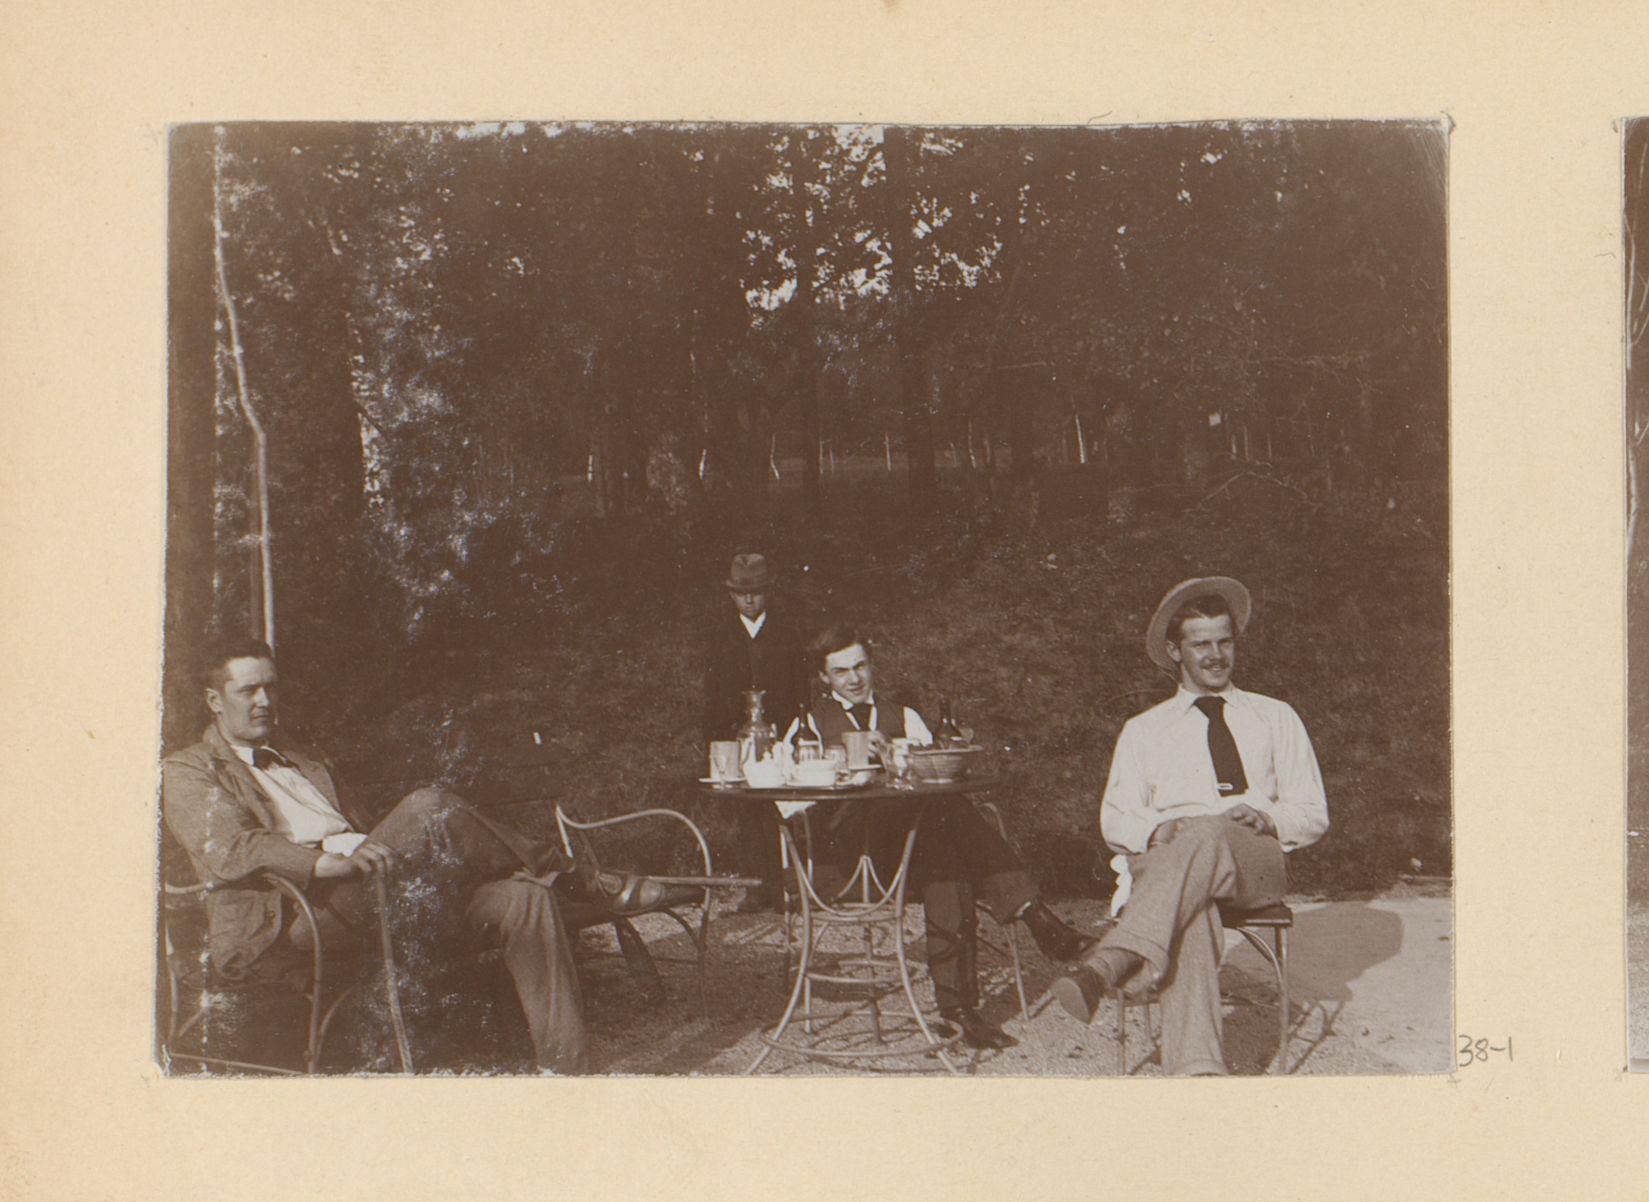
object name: photograph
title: Gezelschap zittend aan tafel naast een tennisbaan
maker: hendrik herman van den berg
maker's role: amateurfotograaf, jurist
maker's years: 1875-1944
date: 1890-1894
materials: paper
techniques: collodion silver print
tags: afternoon tea - cc - out of doors, historical persons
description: Foto 1 op albumblad 38 uit album "Amsterdam 1890-1894".